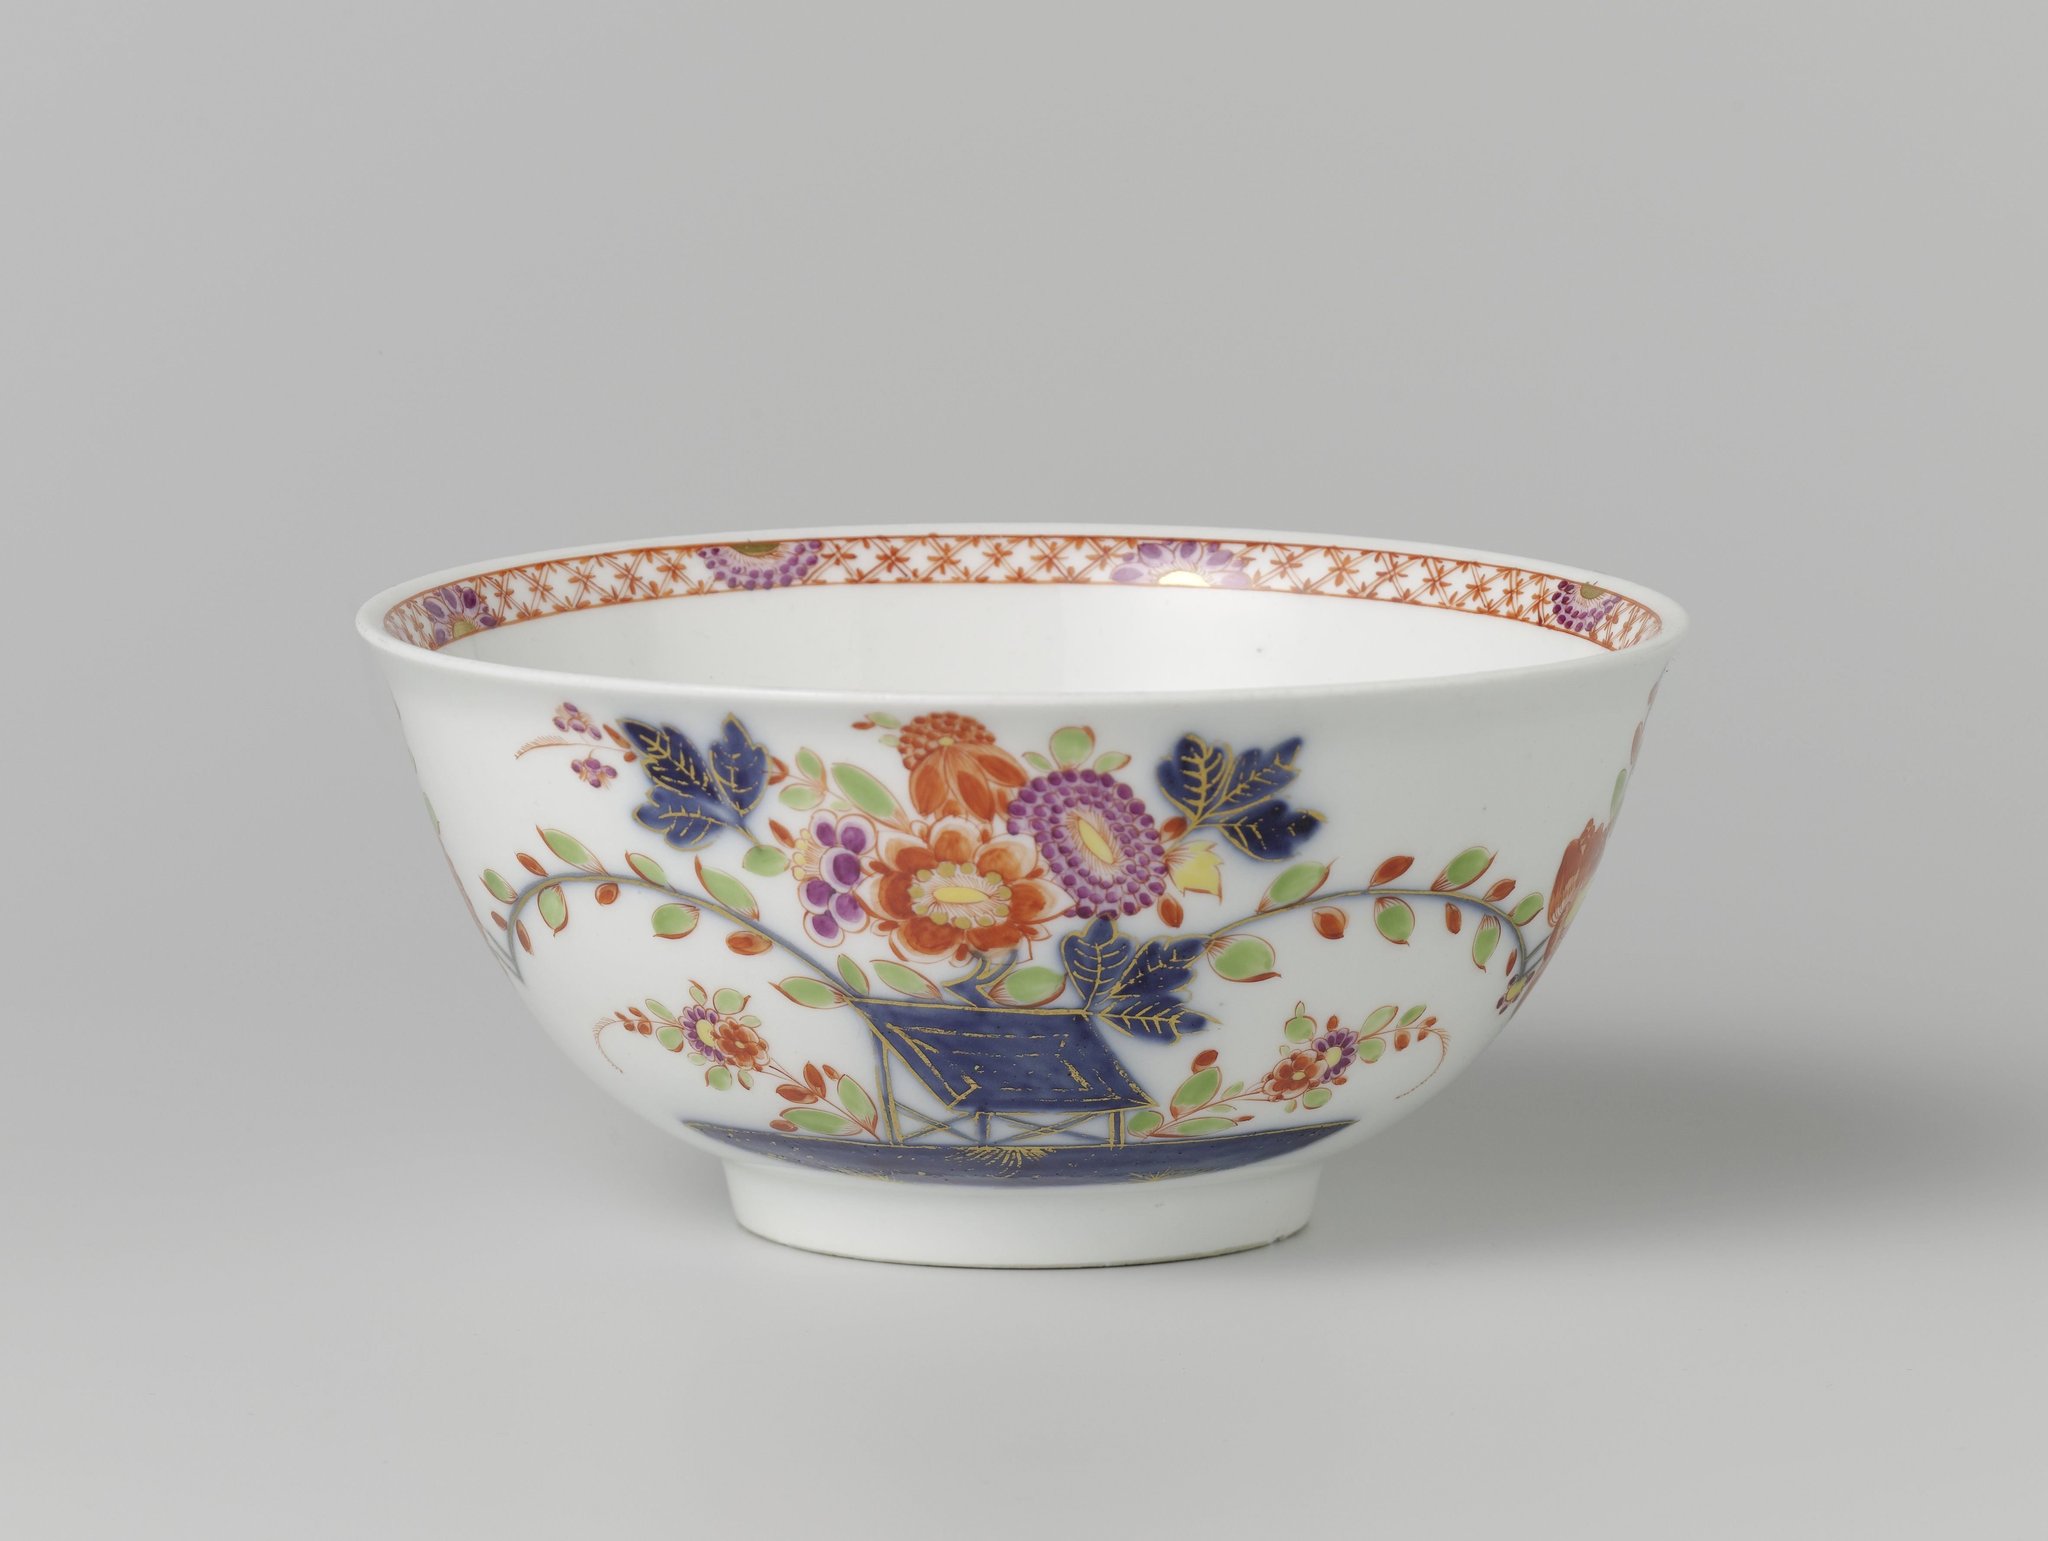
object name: slop bowl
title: Spoelkom, veelkleurig beschilderd met Indianische Blumen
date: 1730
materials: porcelain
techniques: painted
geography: meissen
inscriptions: mark: ‘*I’, mark: ‘//’, factory mark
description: Spoelkom. Porselein. Meissen, ca. 1730. Legaat jkvr. barones van Brakell tot den Brakell, 1904.